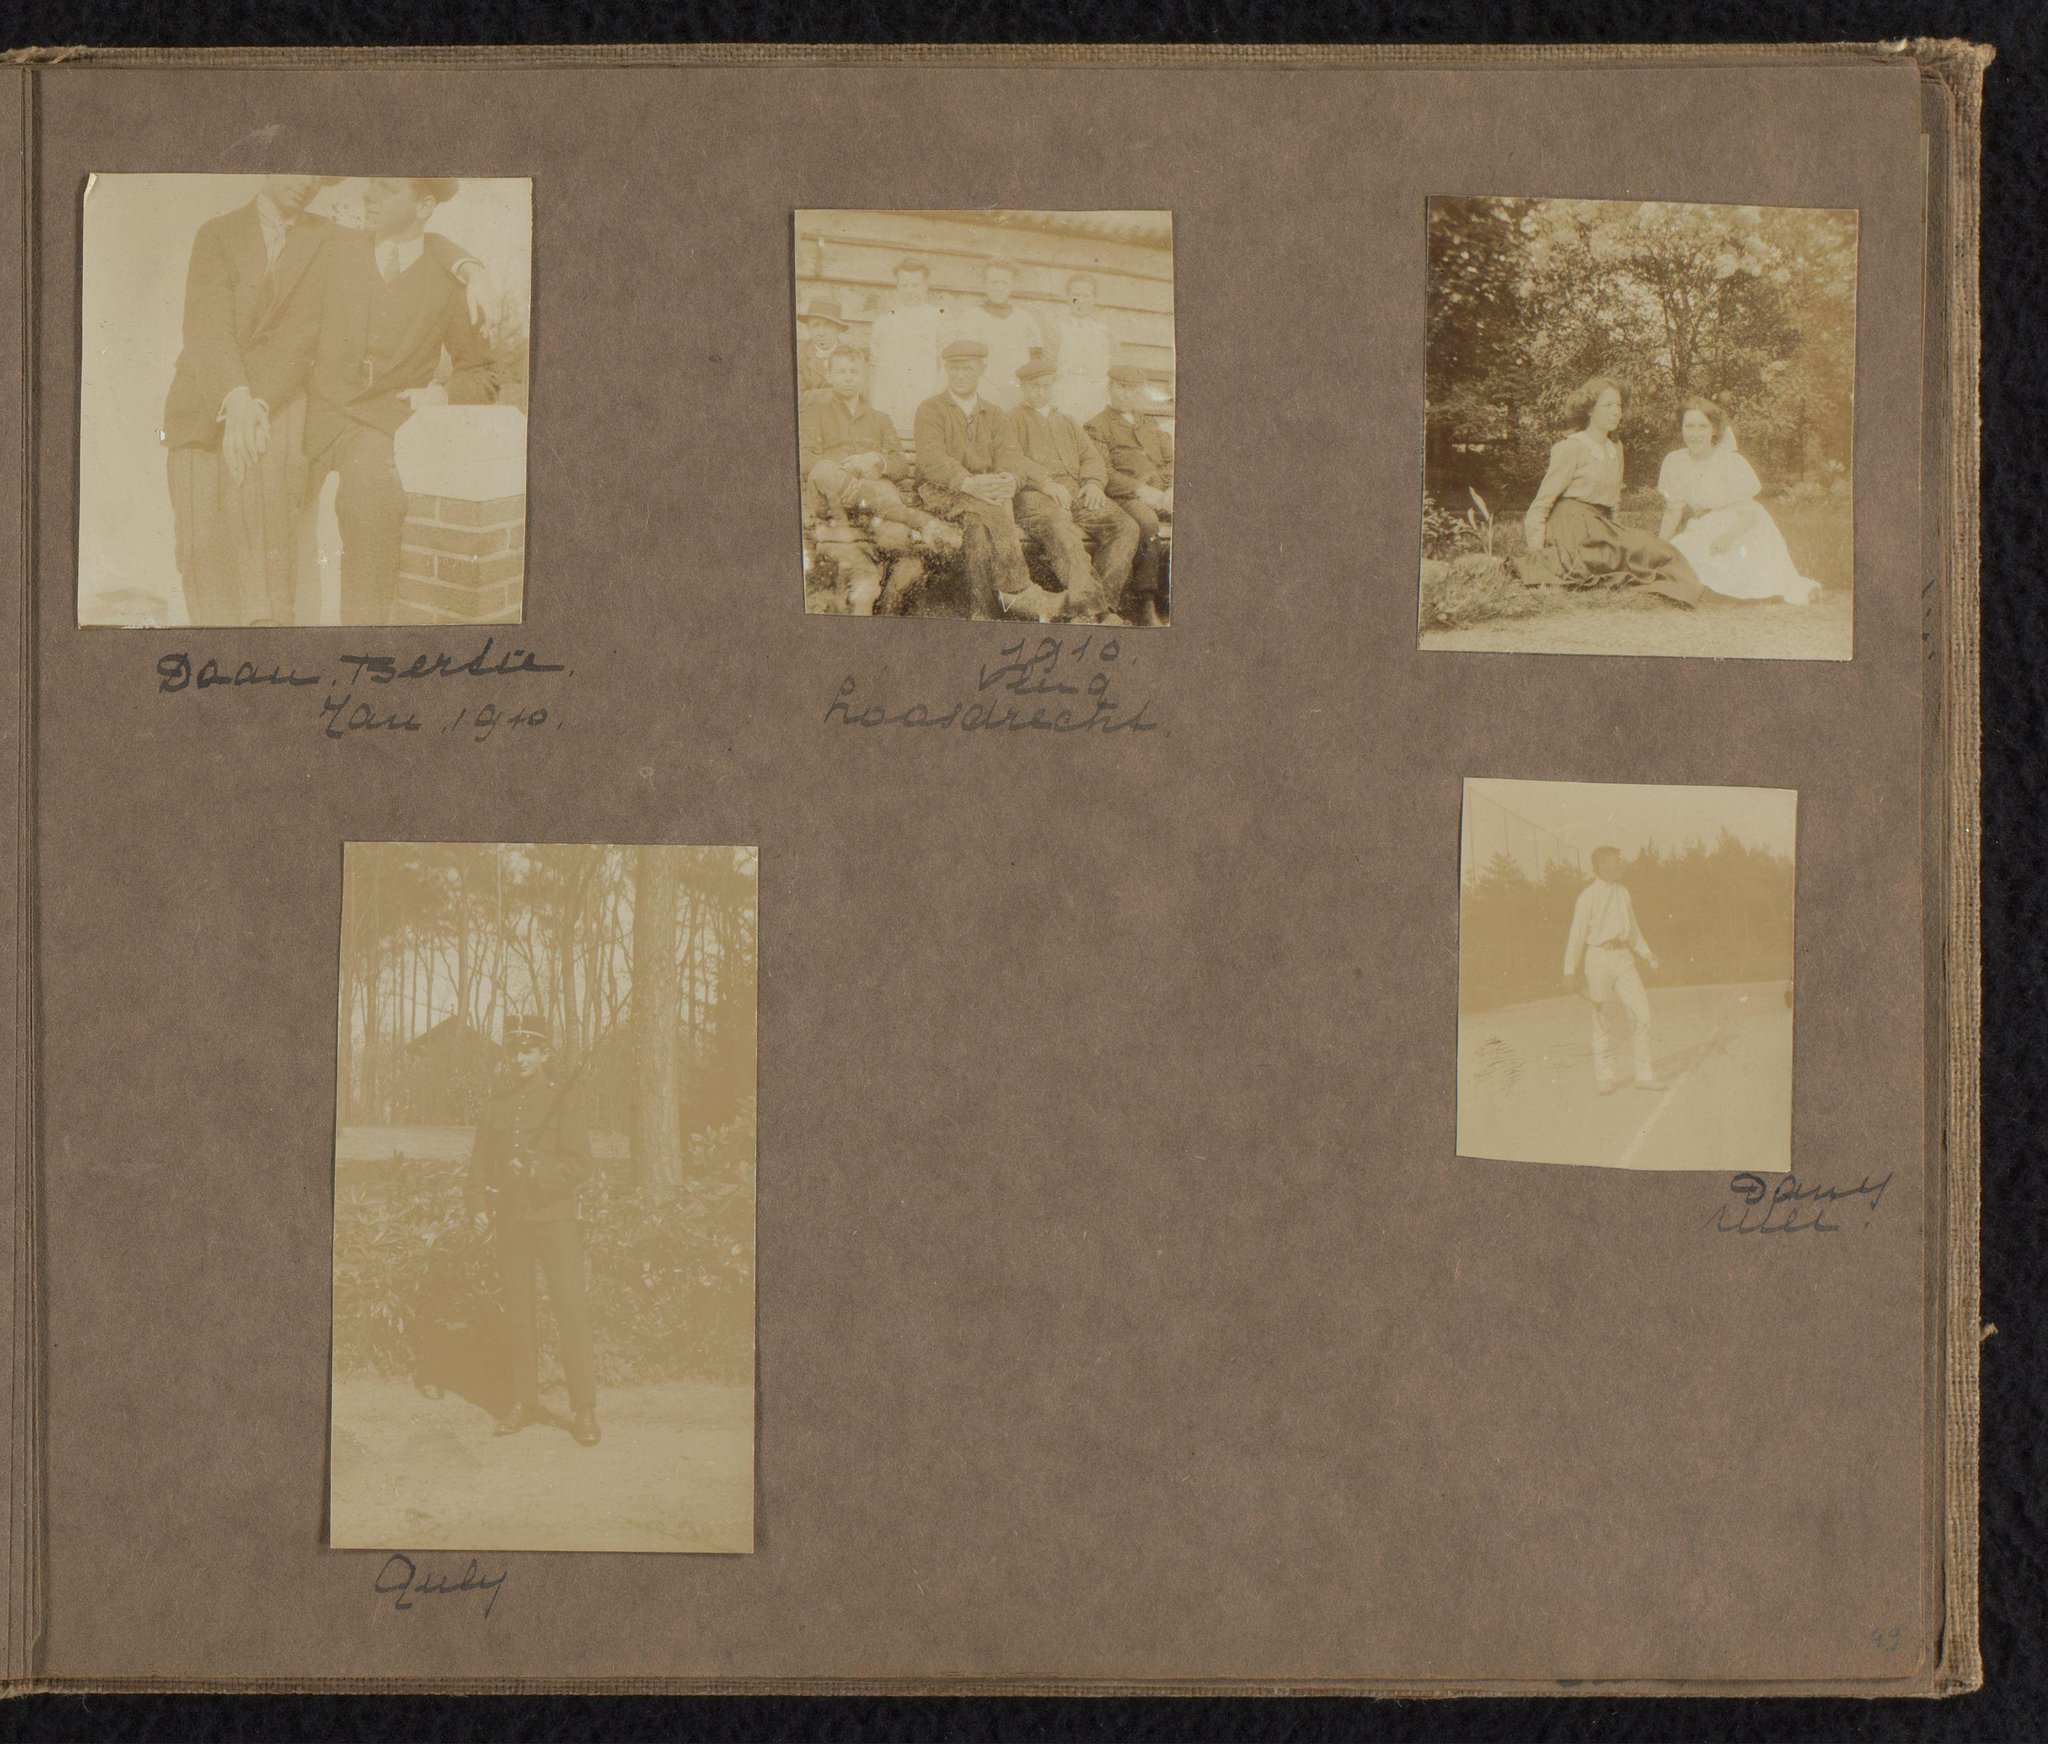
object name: photograph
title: Vijf foto's uit de kring van Loentje Onnen, onder andere Guly Boissevain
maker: carolina frederika onnen (lien/loen)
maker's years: 1896-1983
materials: paper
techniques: gelatin silver print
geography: hilversum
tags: historical persons, friends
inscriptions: inscription: ‘1910/ [...] Loosdrecht’, inscription: ‘Dany/ Mei’, inscription: ‘Daan Bertie/ Jan. 1910’, inscription: ‘Guly’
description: Deze foto's maken deel uit van een album.